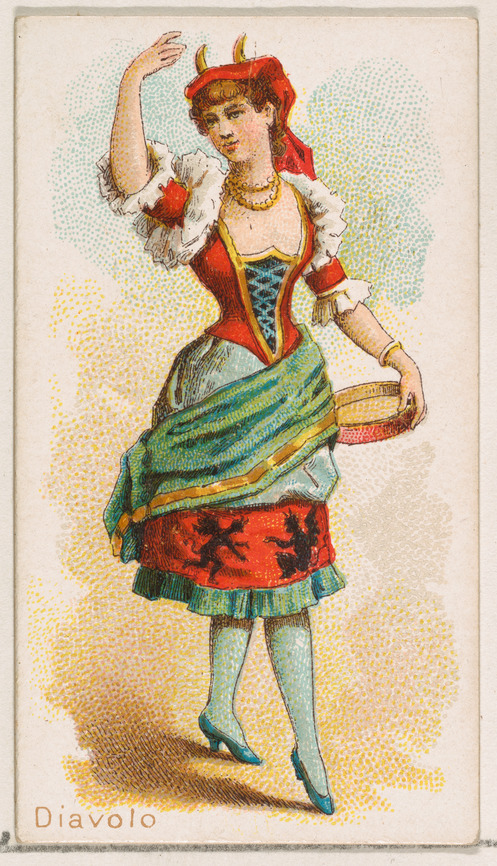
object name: print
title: Diavolo Dancer, from the Dancing Women series (N186) issued by Wm. S. Kimball & Co.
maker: william s. kimball & company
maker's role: publisher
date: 1889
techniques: color lithograph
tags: women,dancing,dancers